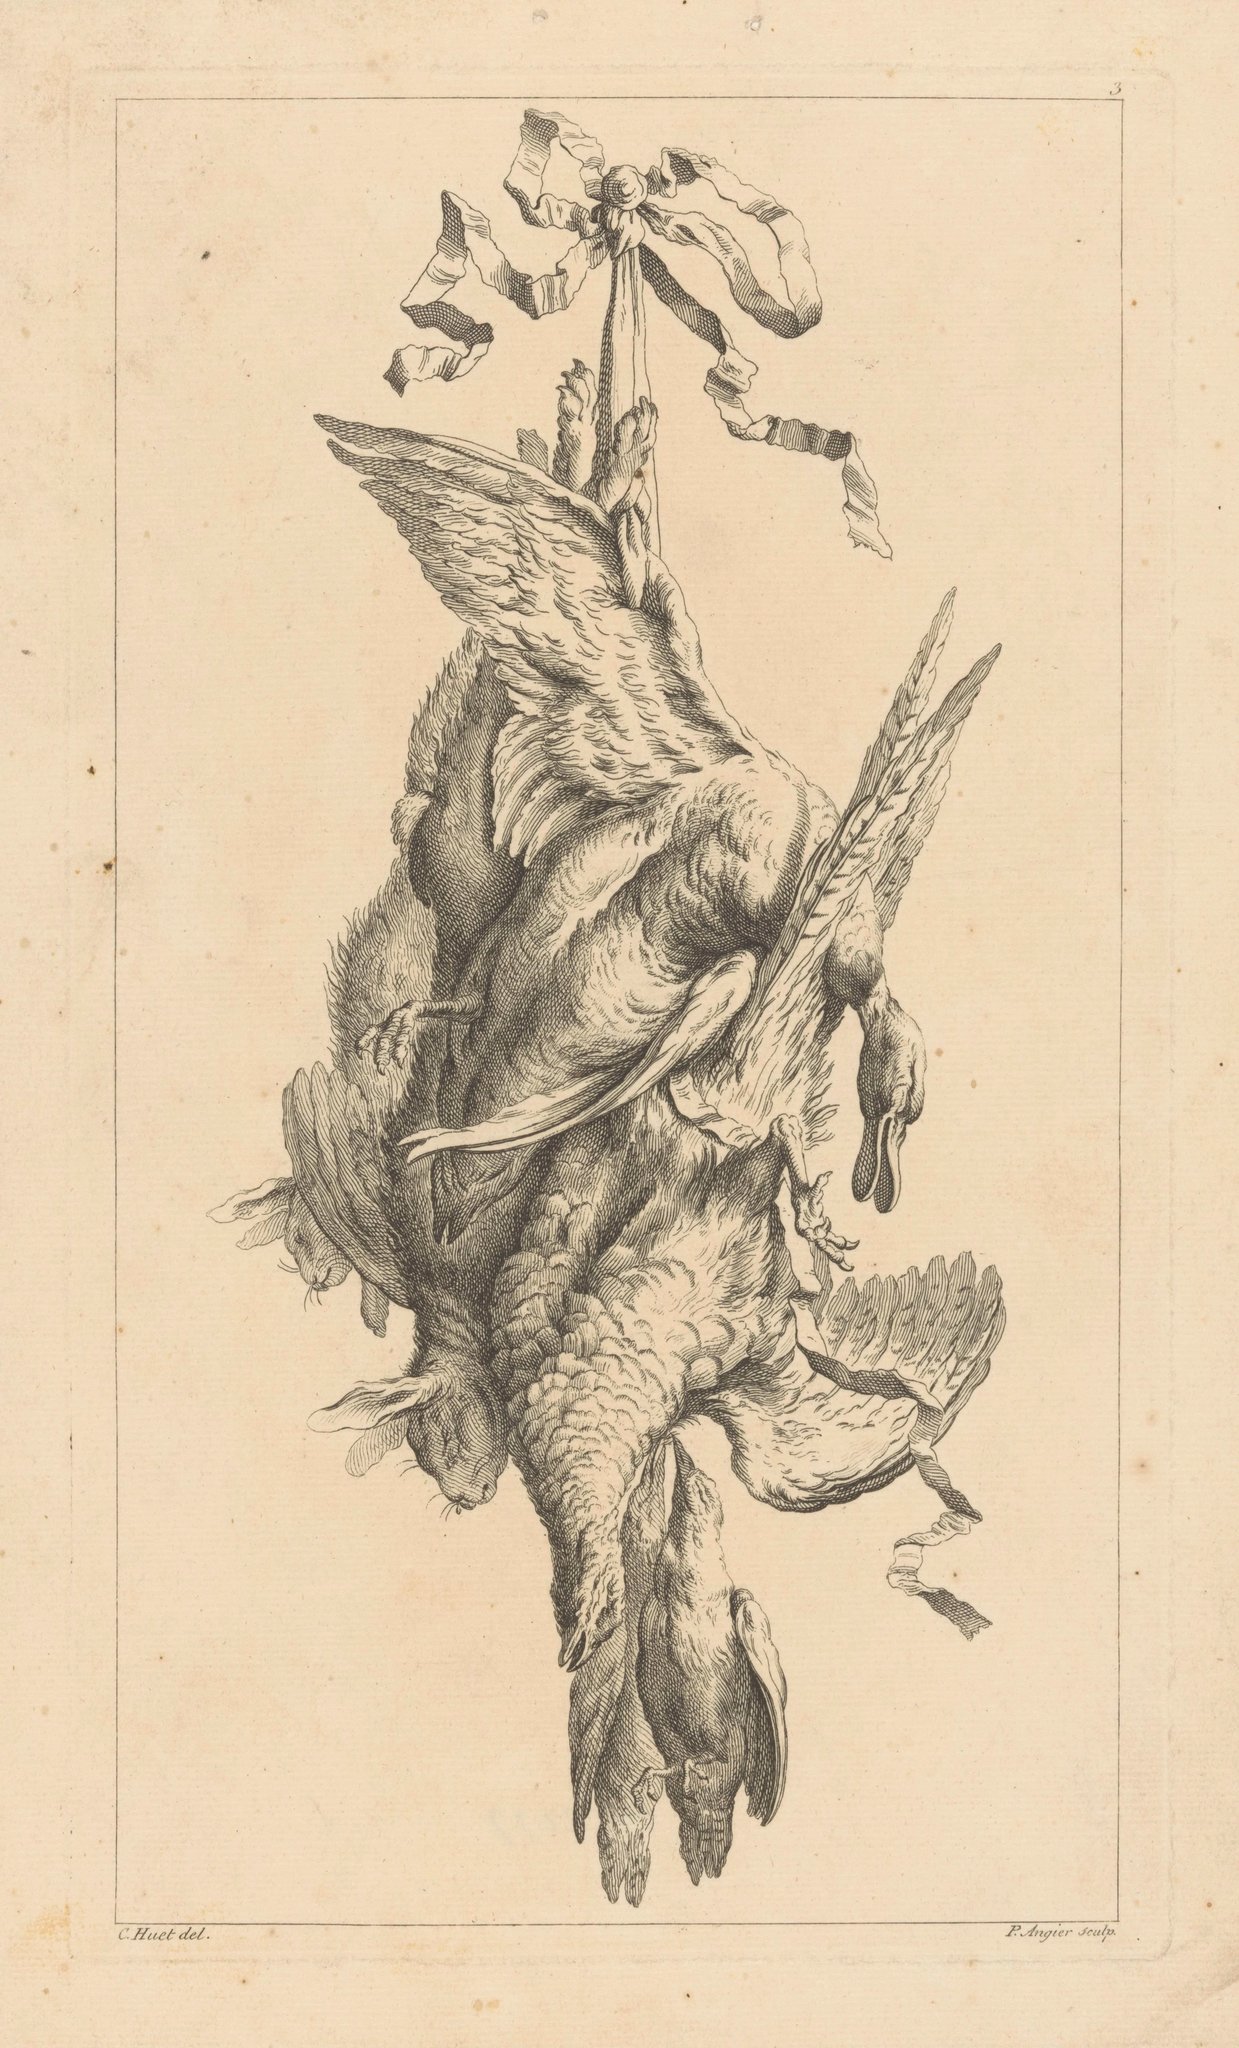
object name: print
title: A New Book of Hunting Trophies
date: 1757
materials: paper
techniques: engraving, etching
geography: london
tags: birds, hunting trophies, rodents: rabbit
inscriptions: collector's mark: Lugt 2760, collector's mark: Lugt 2228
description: Een jachttrofee met een eend, twee konijnen, een fazant en twee kleine vogels.